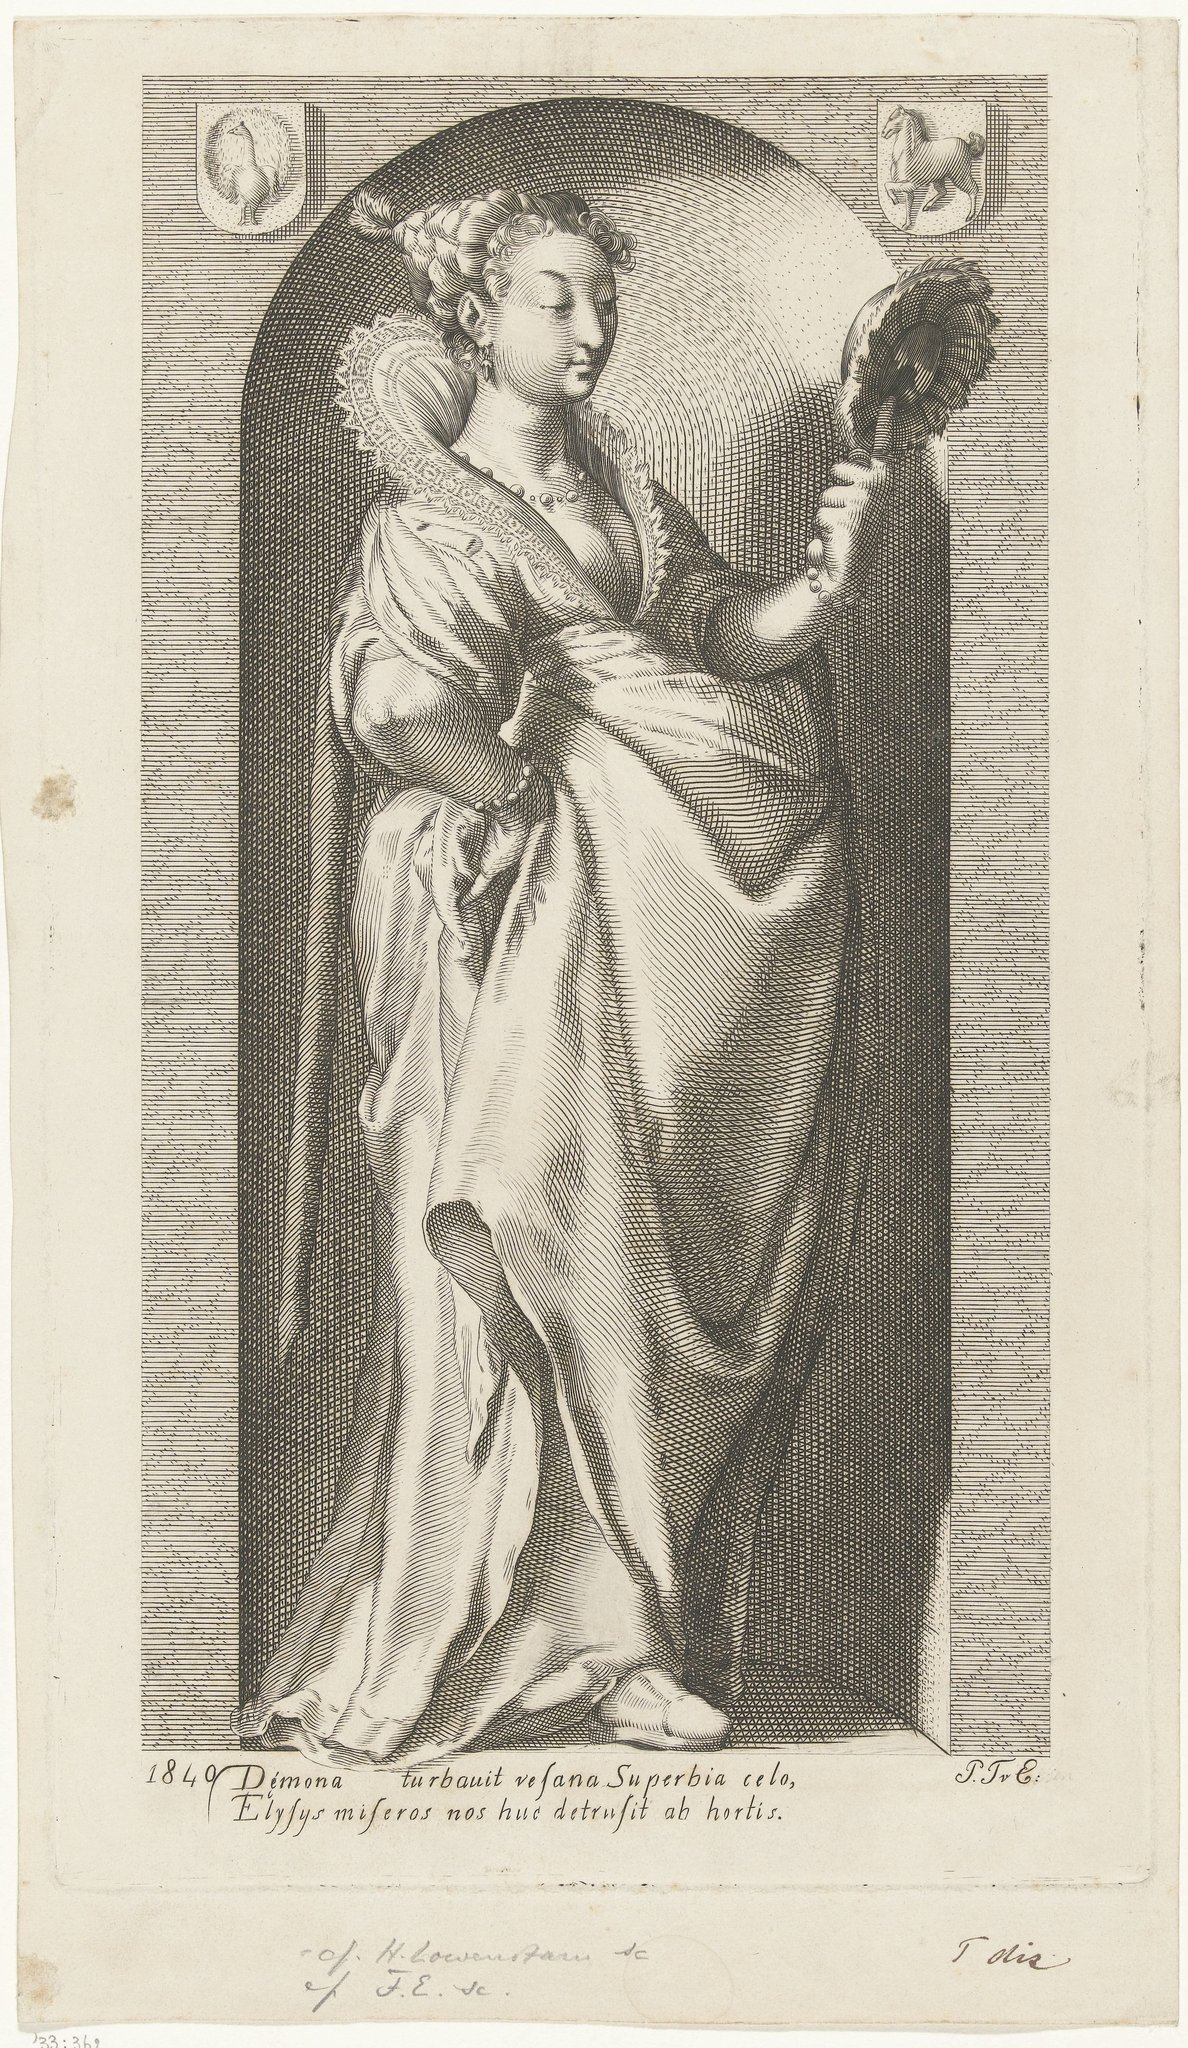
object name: print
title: IJdelheid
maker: paul tetar van elven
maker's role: print maker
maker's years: 1823-1896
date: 1840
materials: paper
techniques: engraving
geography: haarlem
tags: pride; 'superbia' (ripa) ~ personification of one of the seven deadly sins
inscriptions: collector's mark: Lugt 2228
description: Vrouwelijke personificatie van IJdelheid. In een nis staat een vrouw met een spiegel in haar hand. Naast de nis twee emblemen; één met een pauw, de ander met een paard. Onder de voorstelling twee regels Latijn.